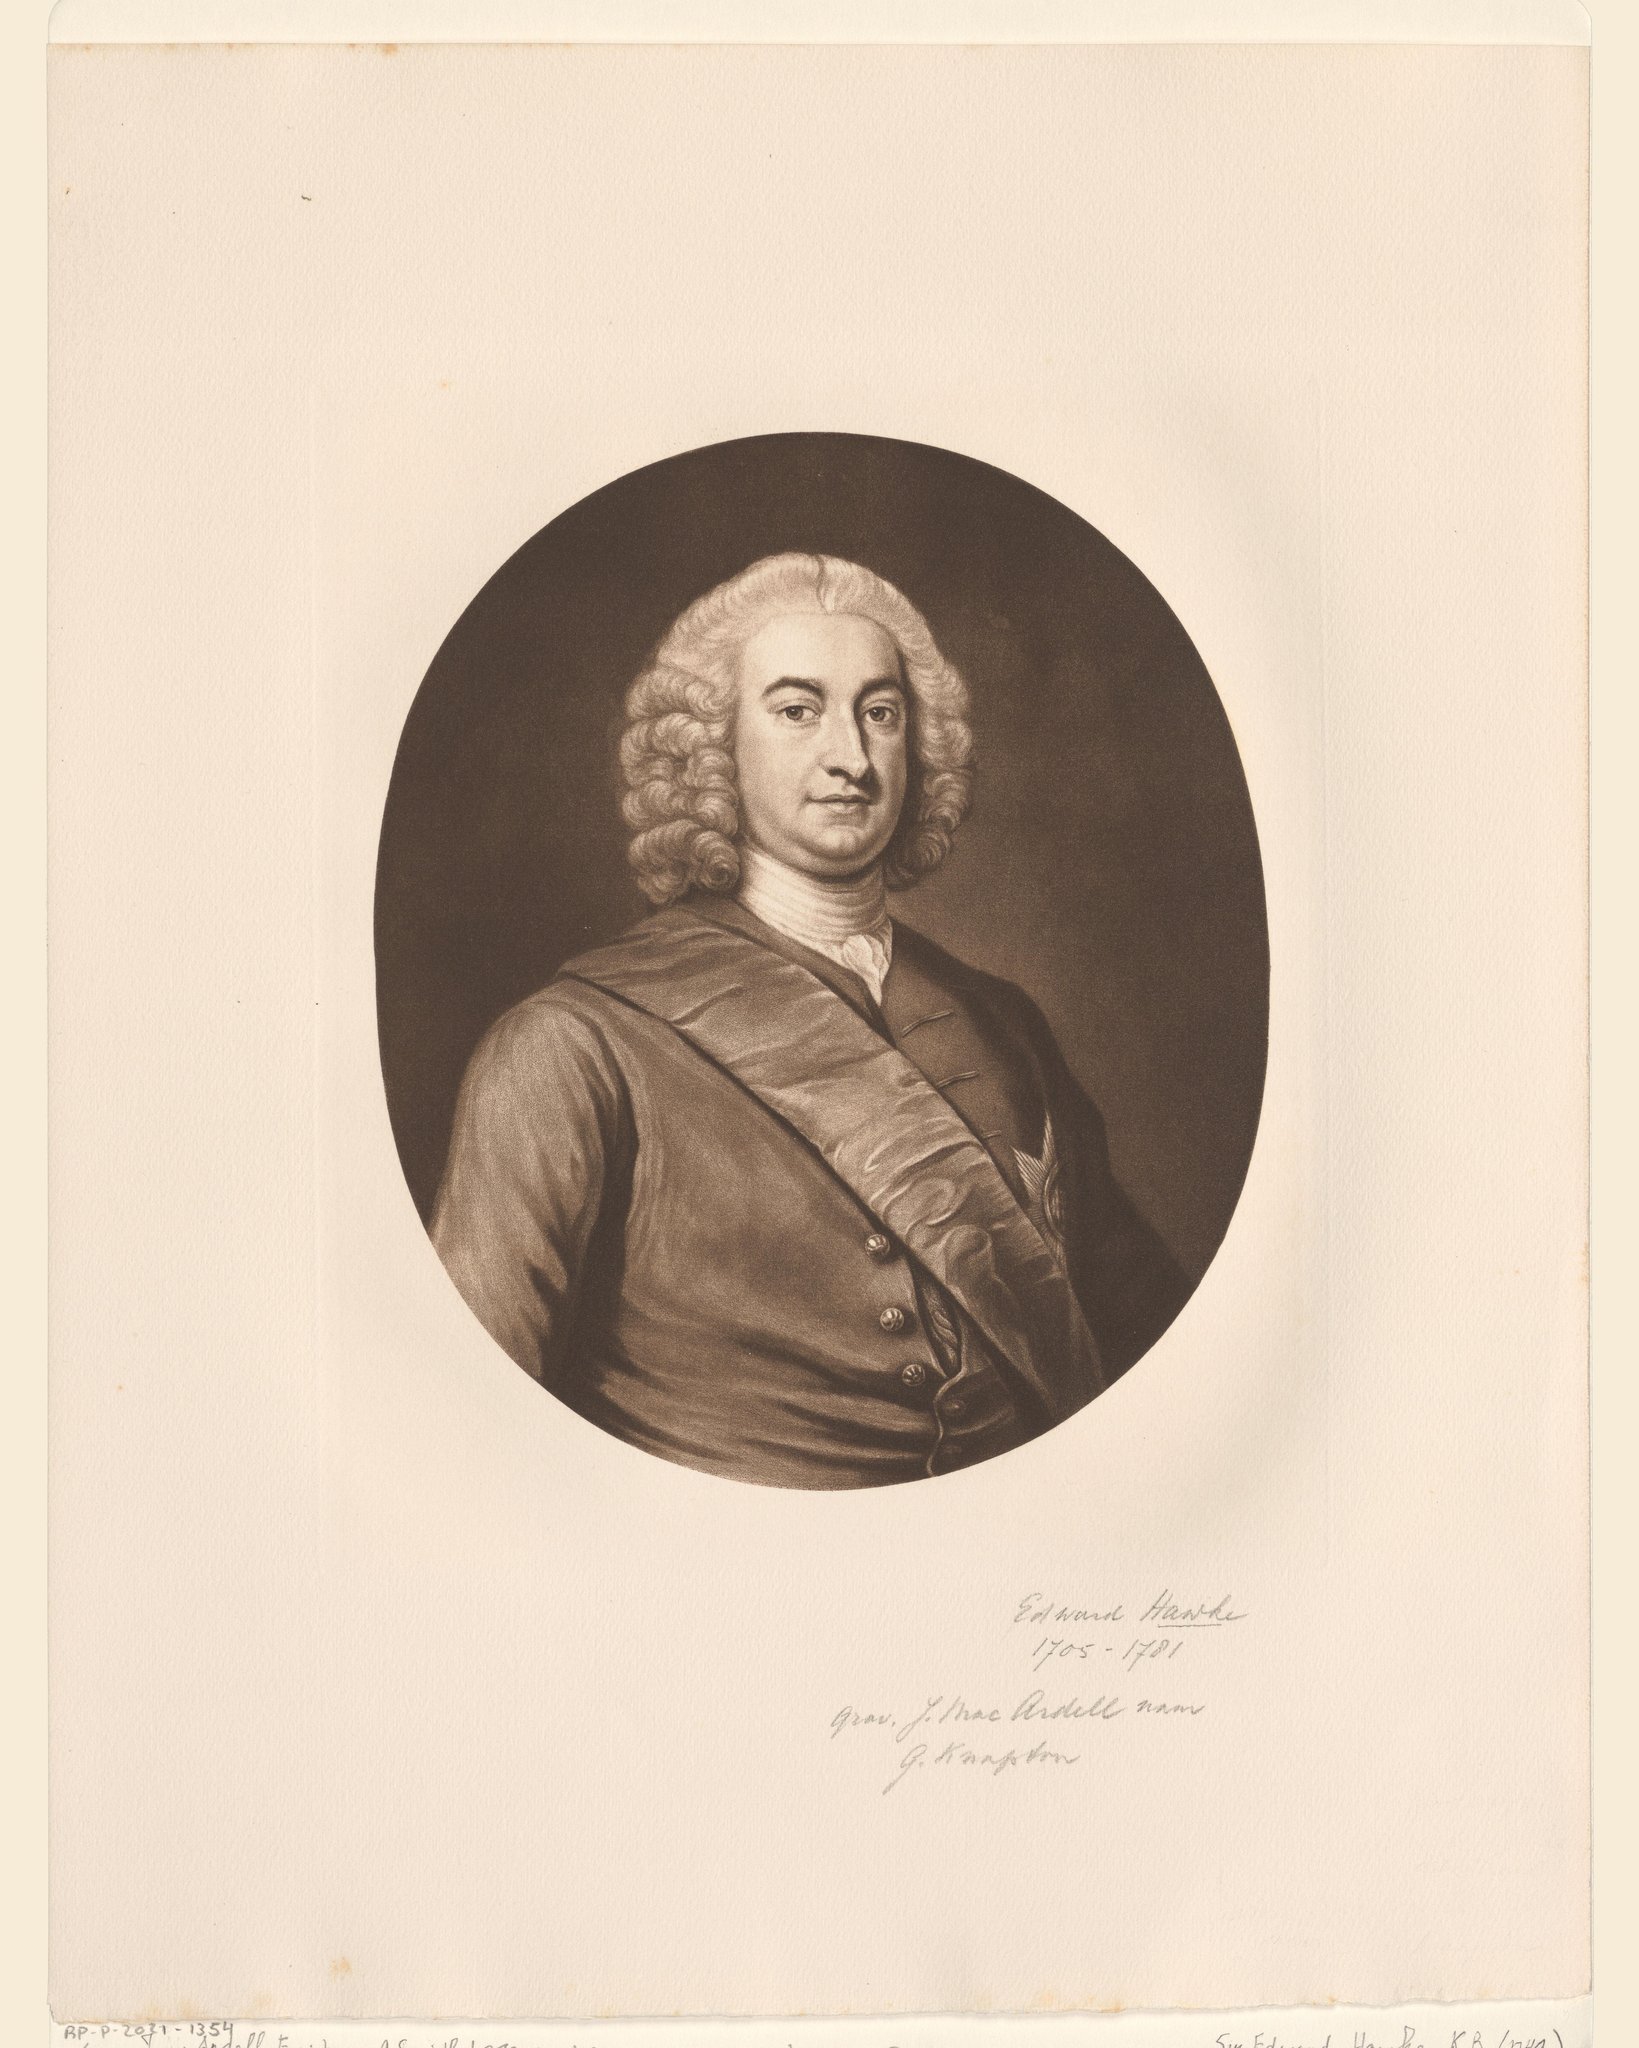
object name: photomechanical print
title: Portret van Edward Hawke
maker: Anonymous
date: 1870-1915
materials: paper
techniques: photoaquatint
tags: edward hawke (1e baron hawke), historical persons, commander-in-chief, admiral